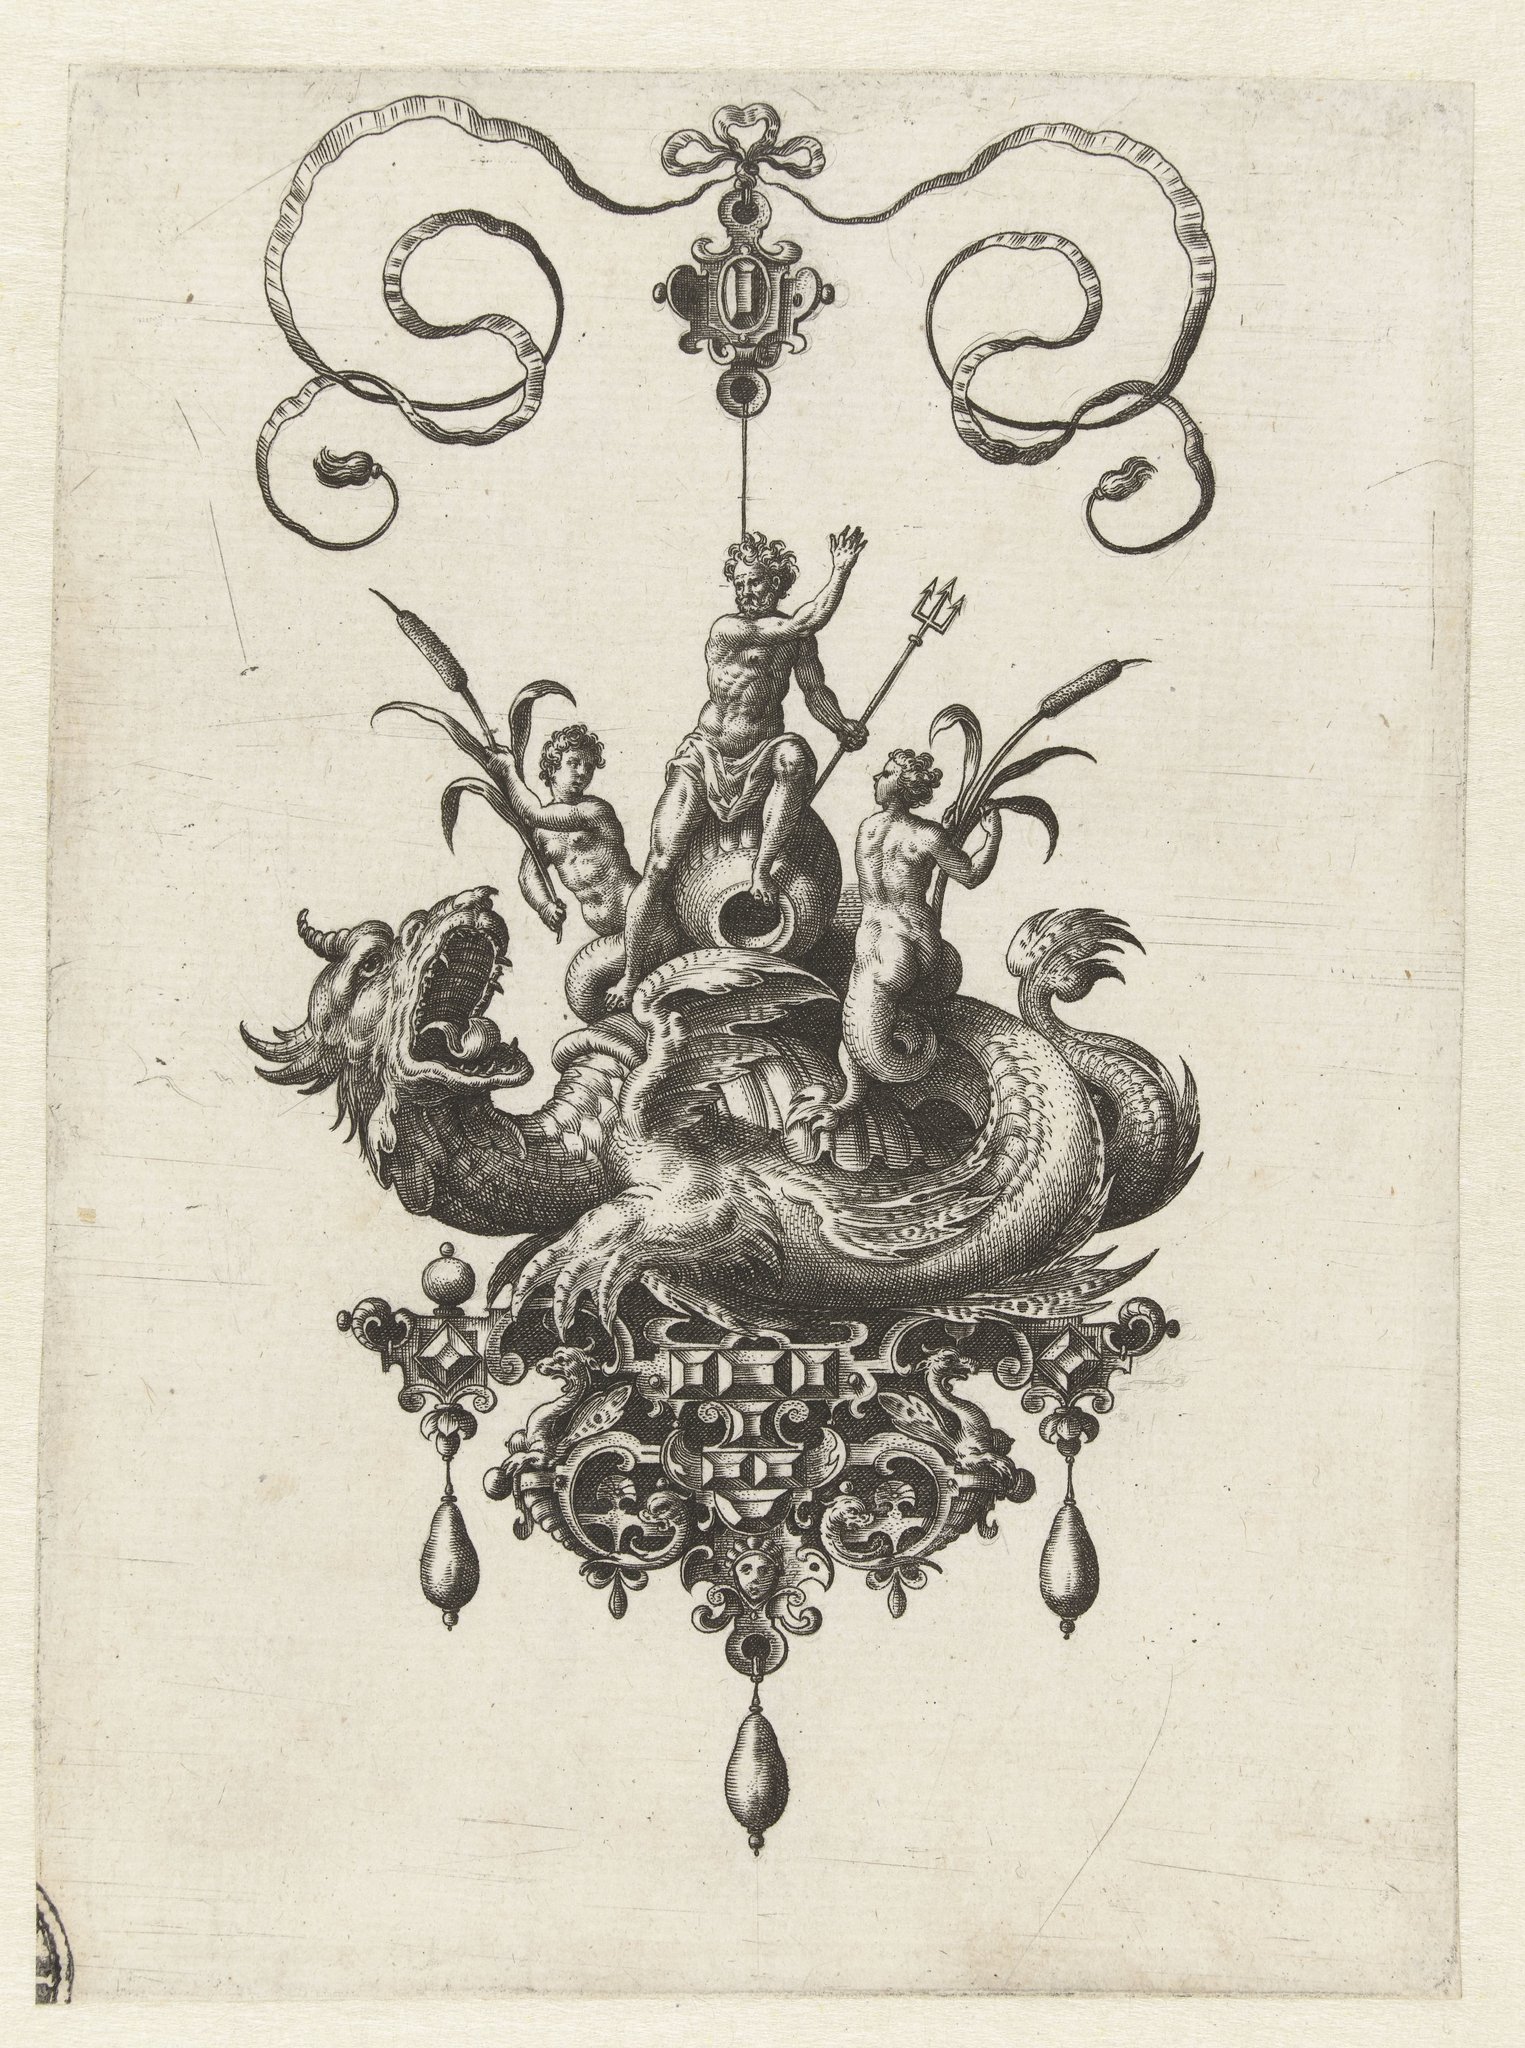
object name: print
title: Hanger met zeedraak, op zijn rug Neptunus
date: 1582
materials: paper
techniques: engraving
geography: netherlands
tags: (story of) neptune (poseidon), pendant, trinket, 'breloque'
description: Op de rug van de zeedraak ligt een vaas waarop Neptunus zit, geflankeerd door twee nereïden met lisdodden. Een van 7 deels genummerde bladen afkomstig uit een serie van 10 bladen met hangers. Aan elke hanger hangen drie parels.